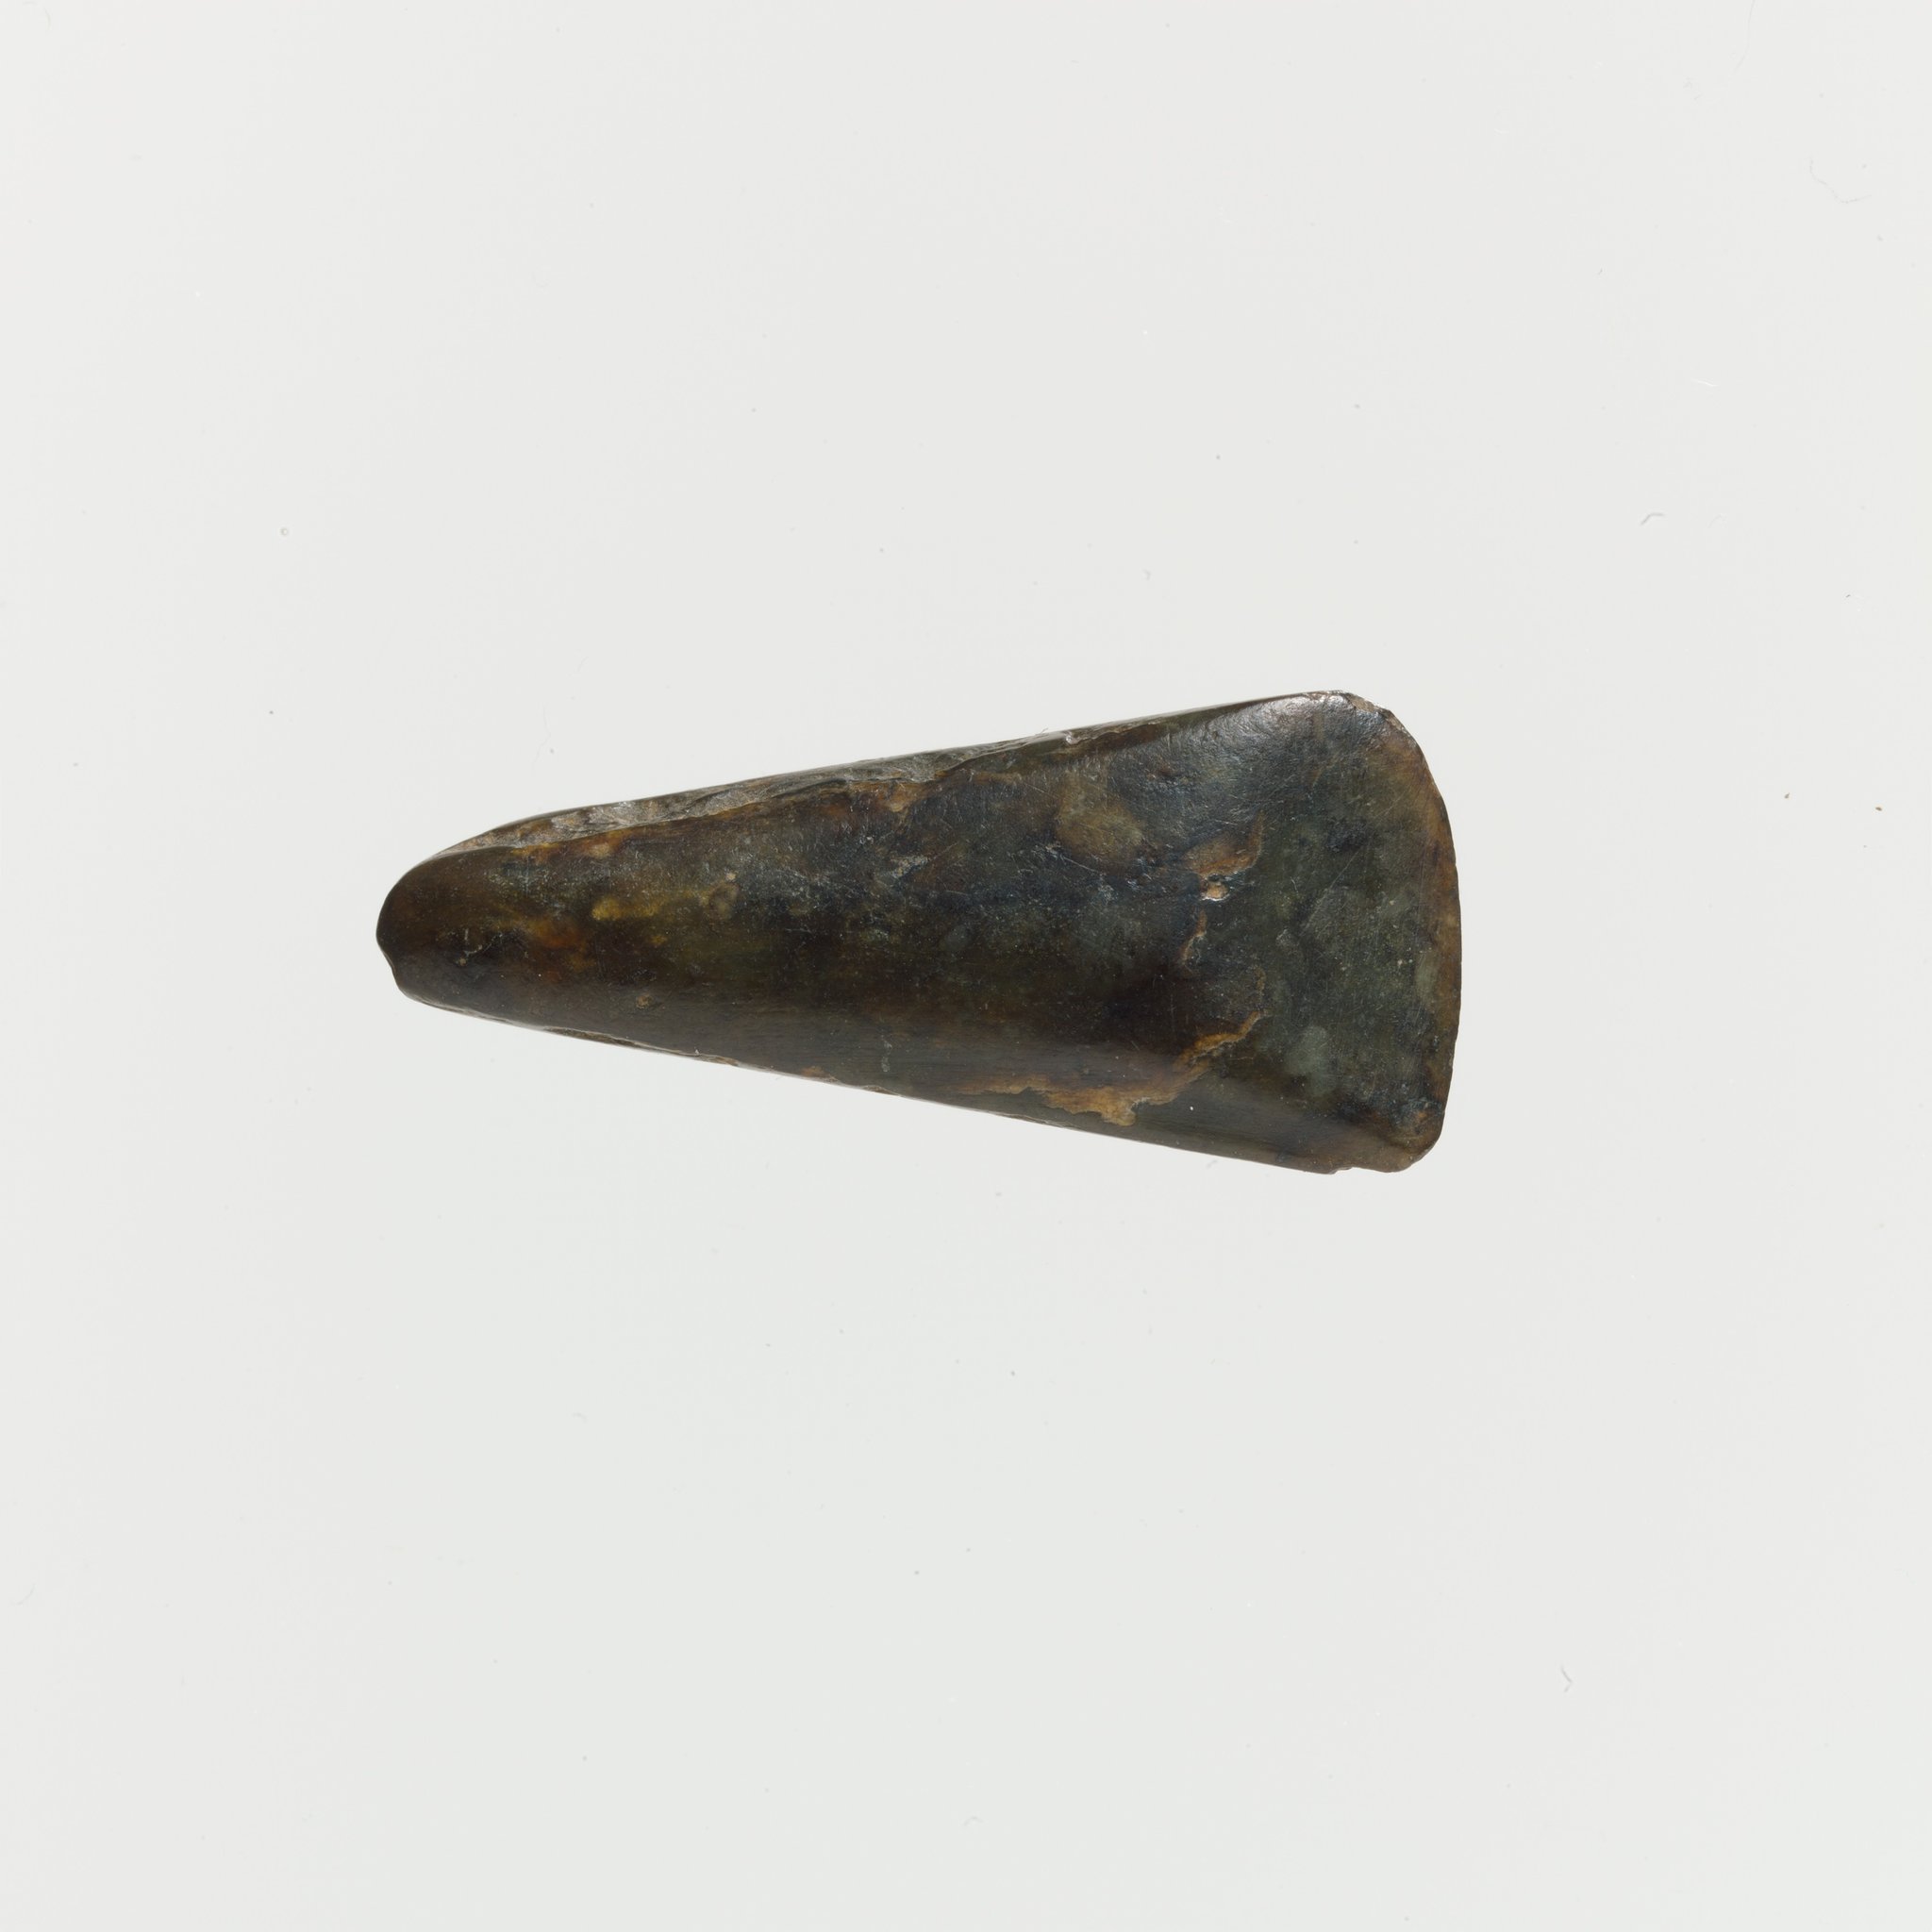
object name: celt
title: Small hornblende triangular axe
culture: cretan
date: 6000-3001 BCE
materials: stone